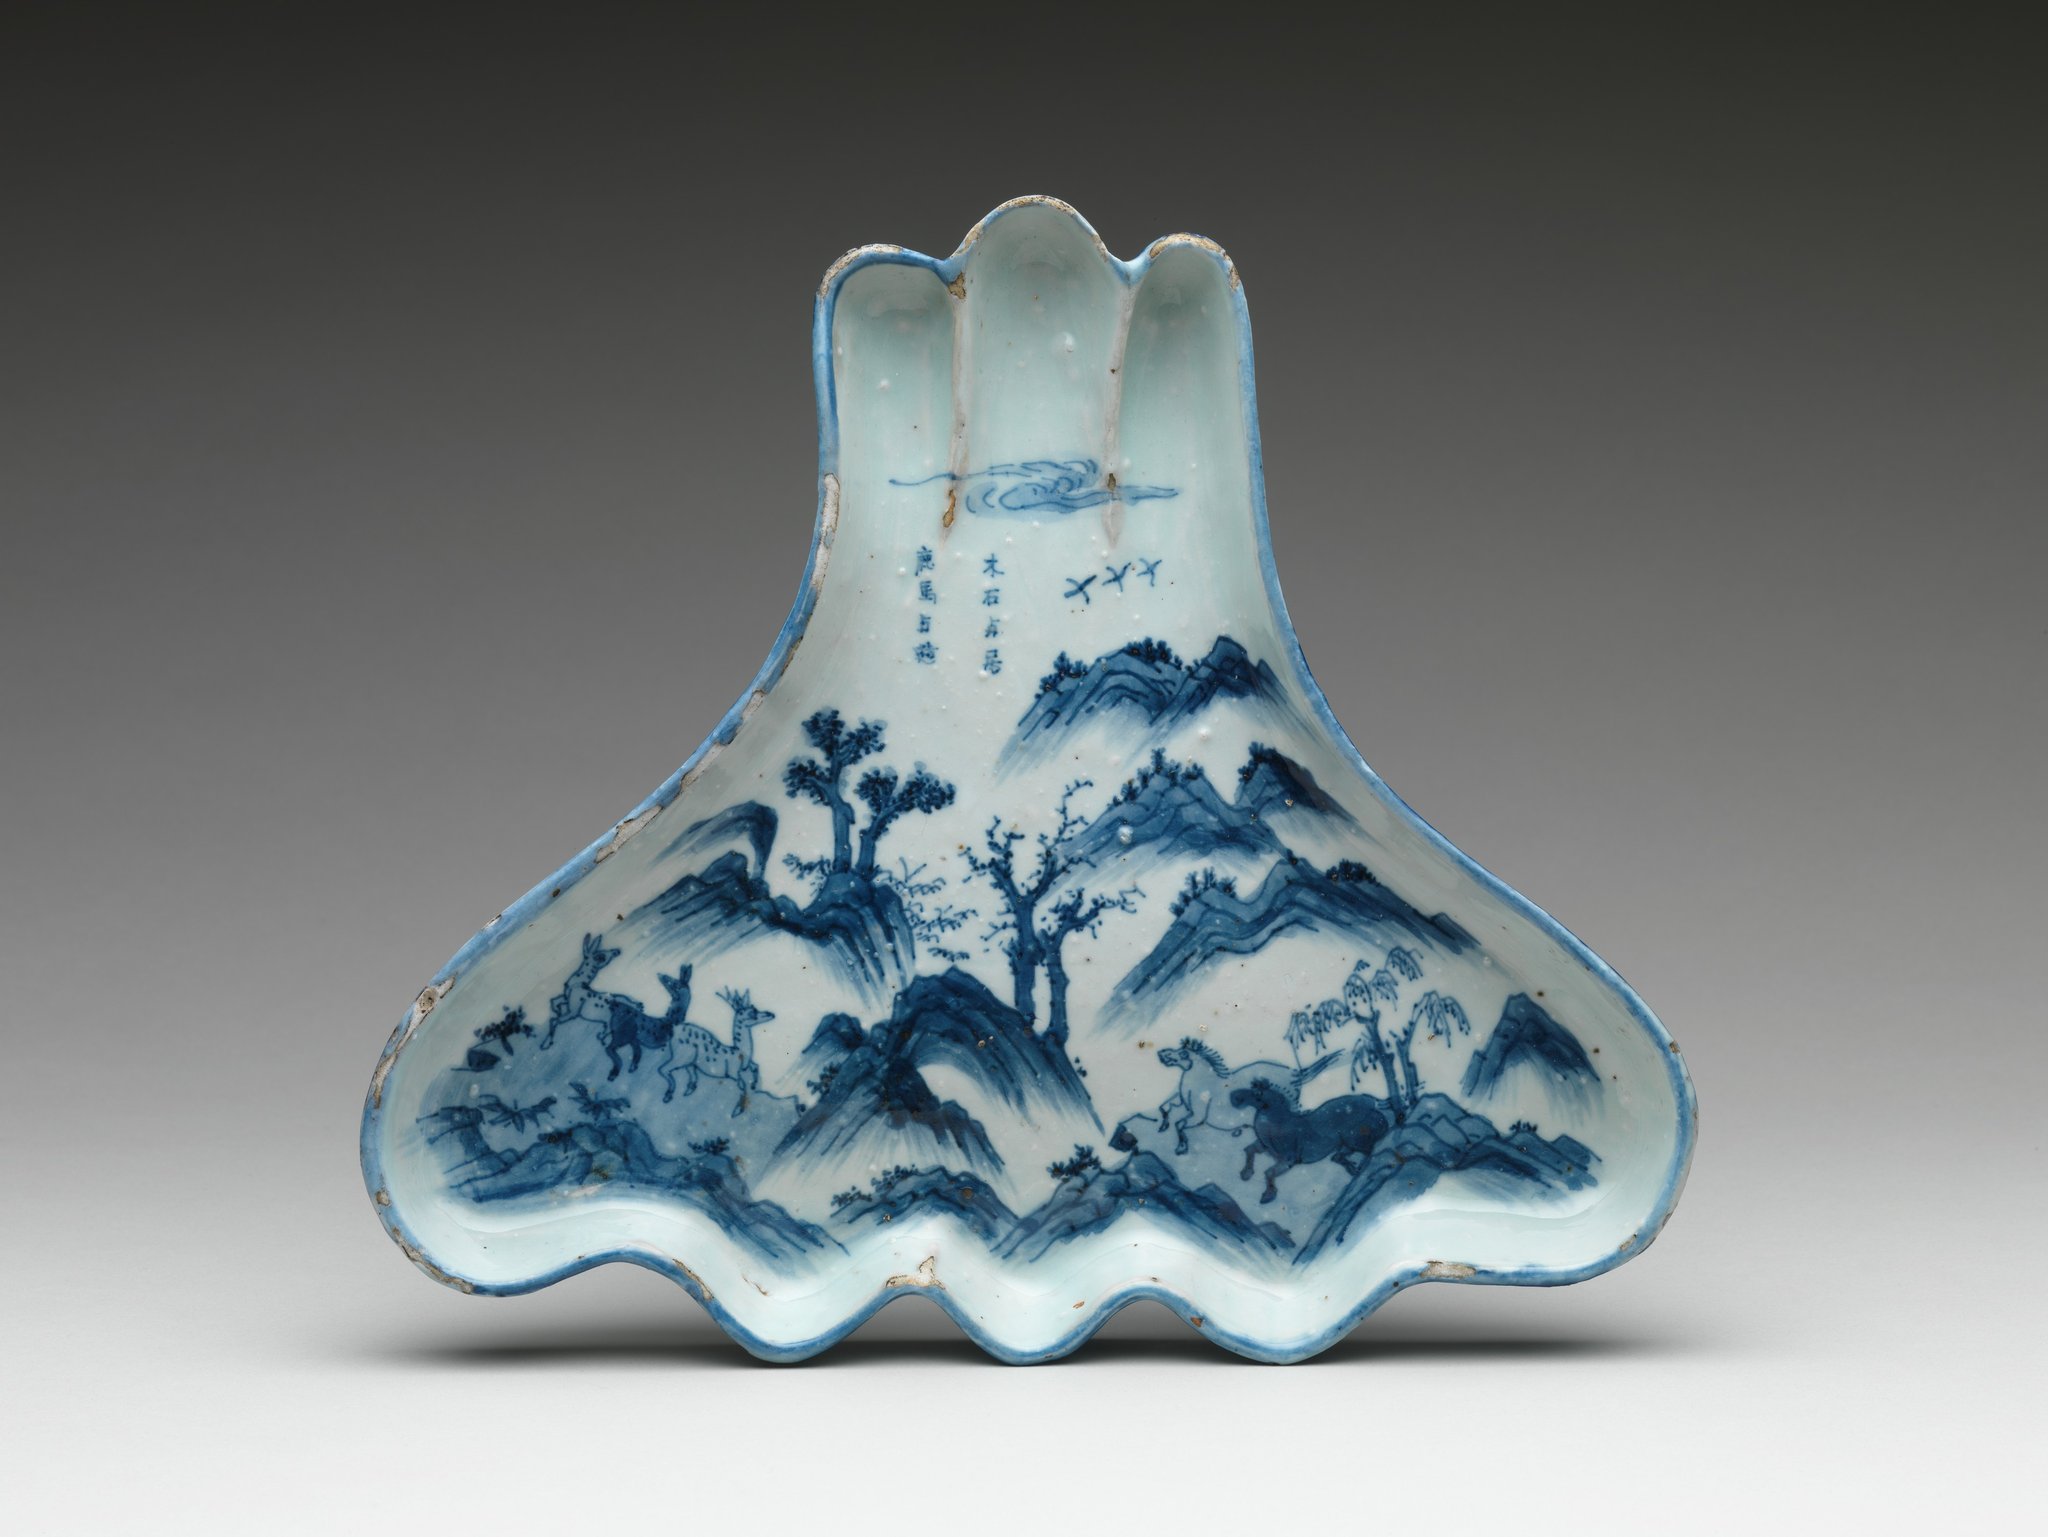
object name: dish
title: Dish in Shape of Mount Fuji with Horses and Deer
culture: chinese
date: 1625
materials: cobalt, glaze, porcelain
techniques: painting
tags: deer,horses,mountains